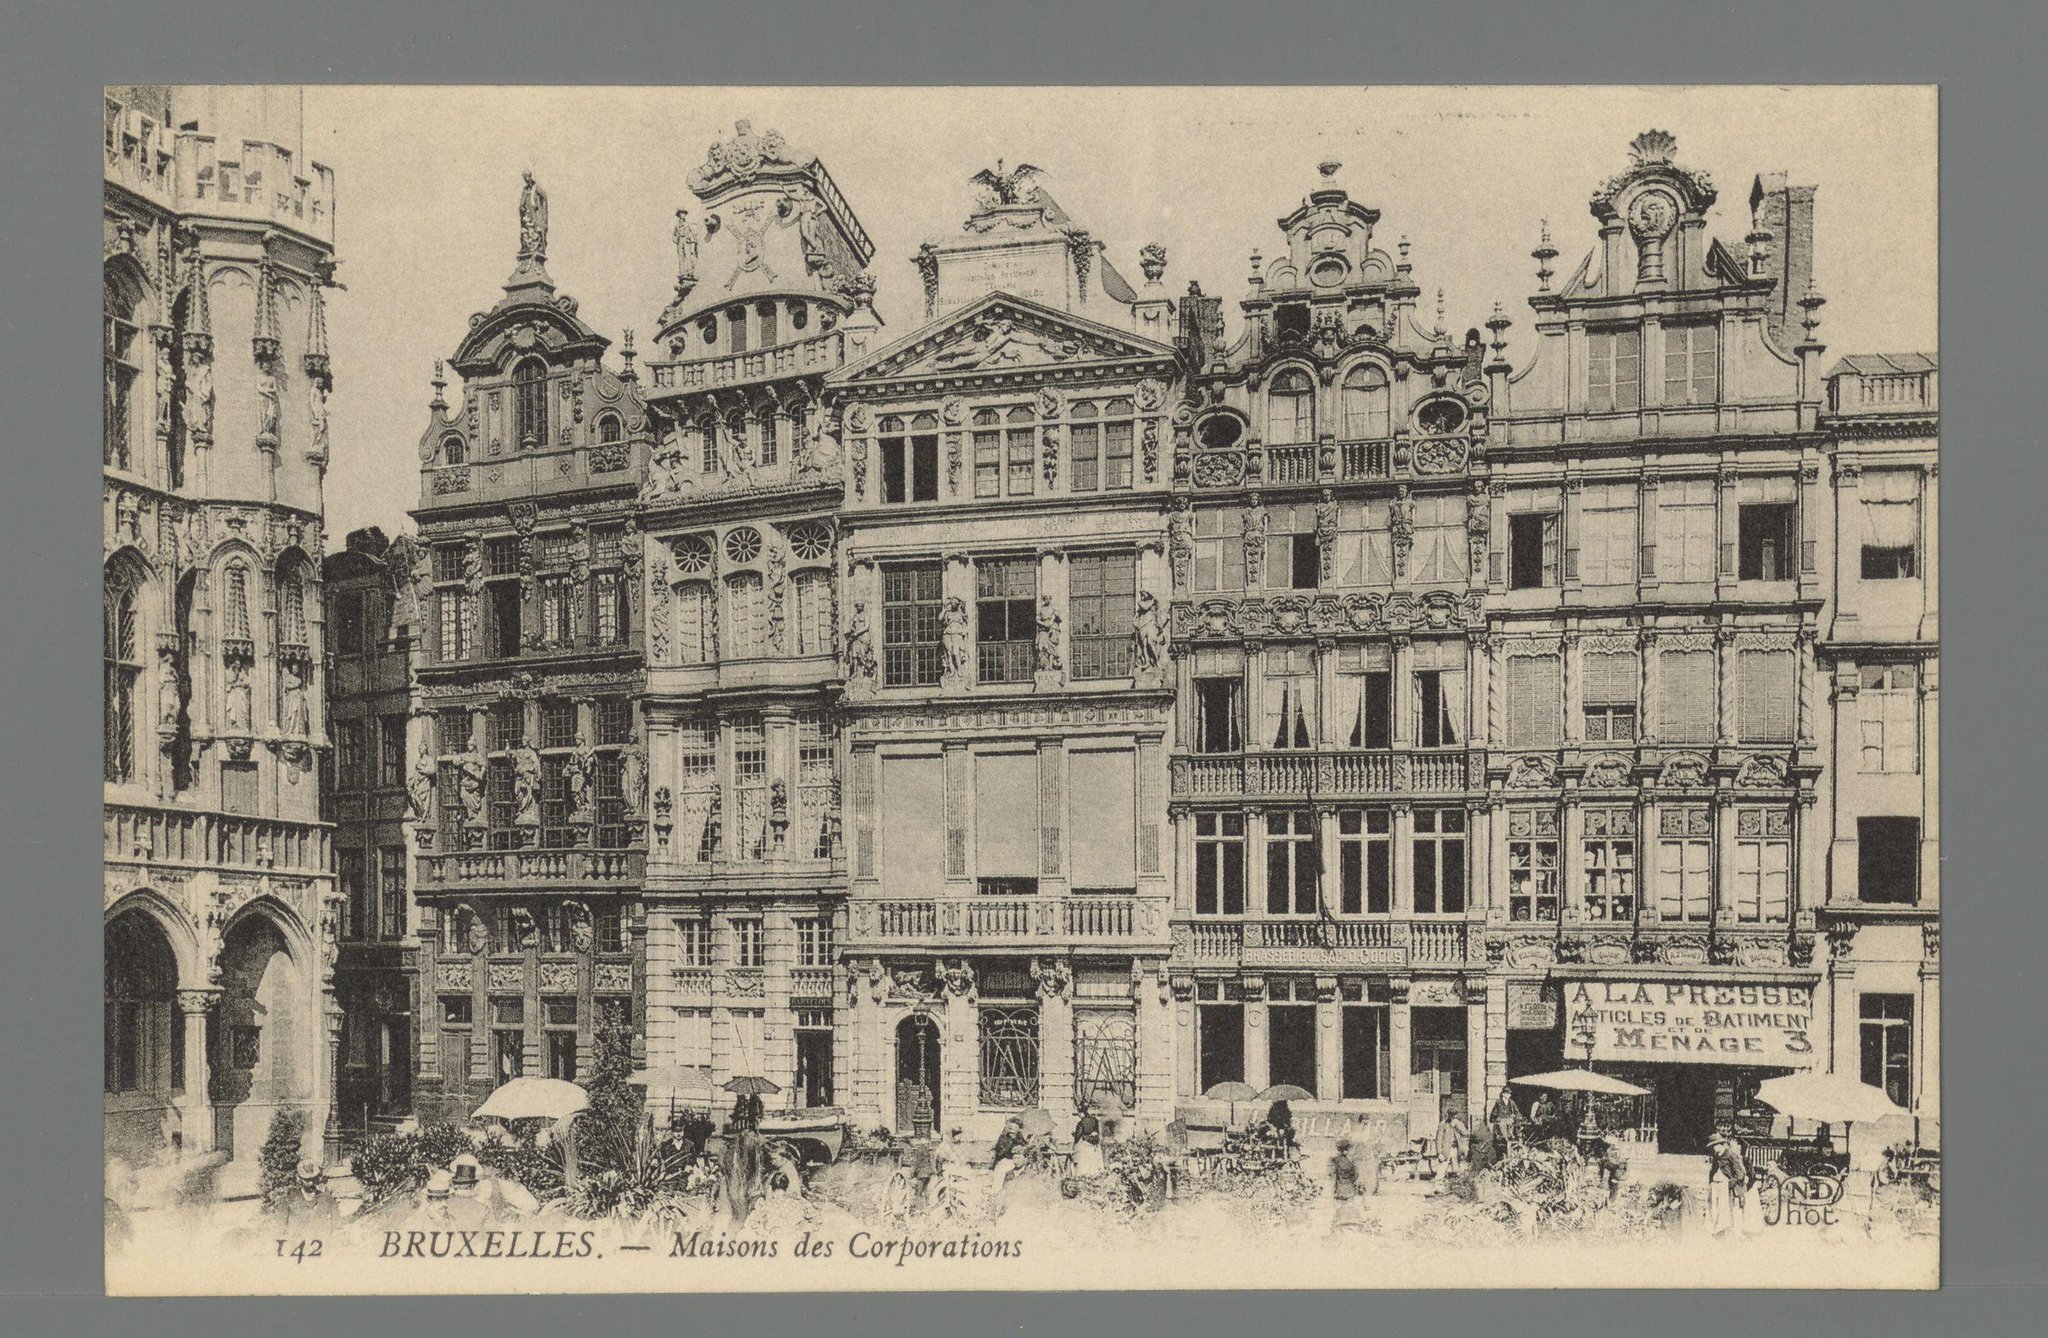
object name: ansichtkaart, prentbriefkaart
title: Bruxelles. Maisons des Corporations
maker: Anonymous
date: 1906-1918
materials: cardboard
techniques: photograph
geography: paris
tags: square, place, circus, etc., city-view, and landscape with man-made constructions (+ city(-scape) with figures, staffage)